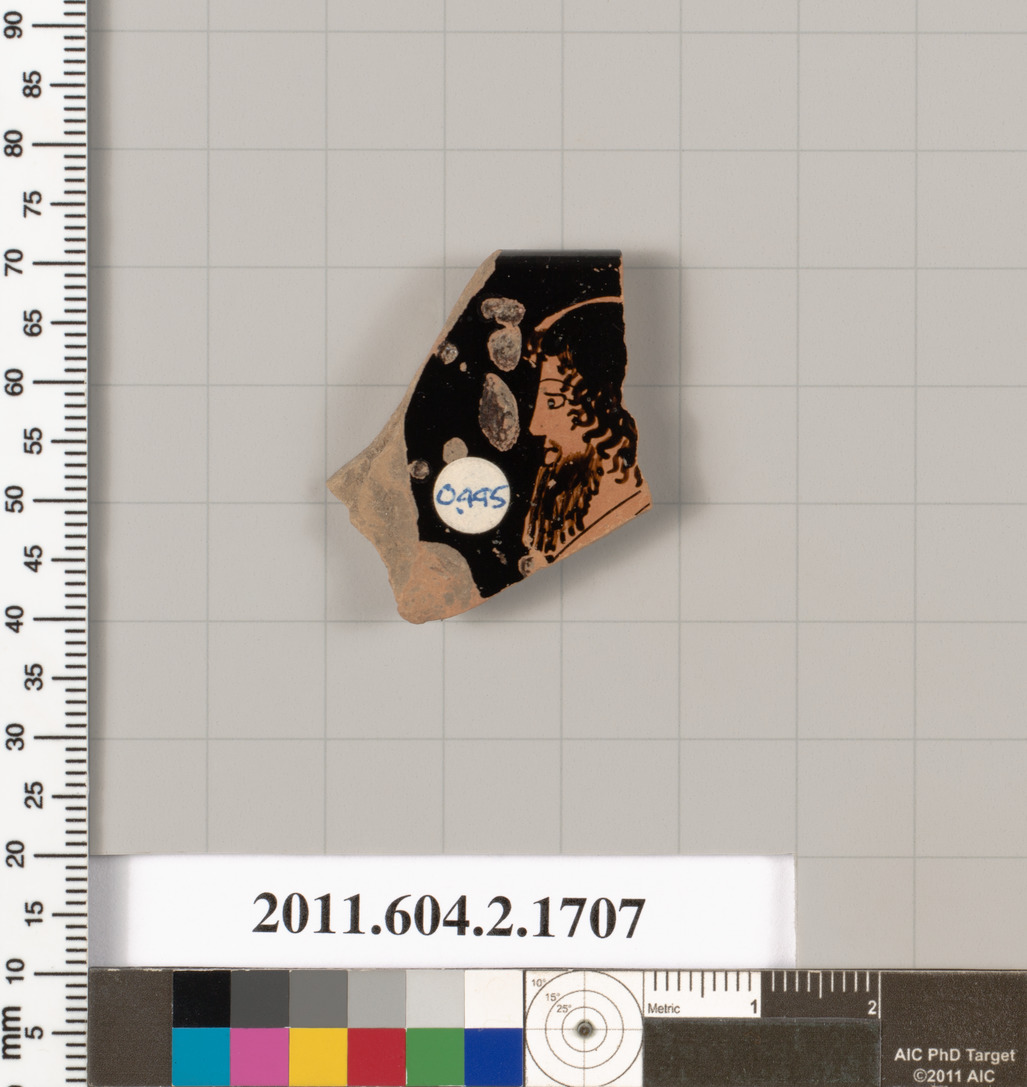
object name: skyphos fragment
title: Terracotta rim fragment of a skyphos (deep drinking cup)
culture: greek, attic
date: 475-451 BCE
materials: terracotta